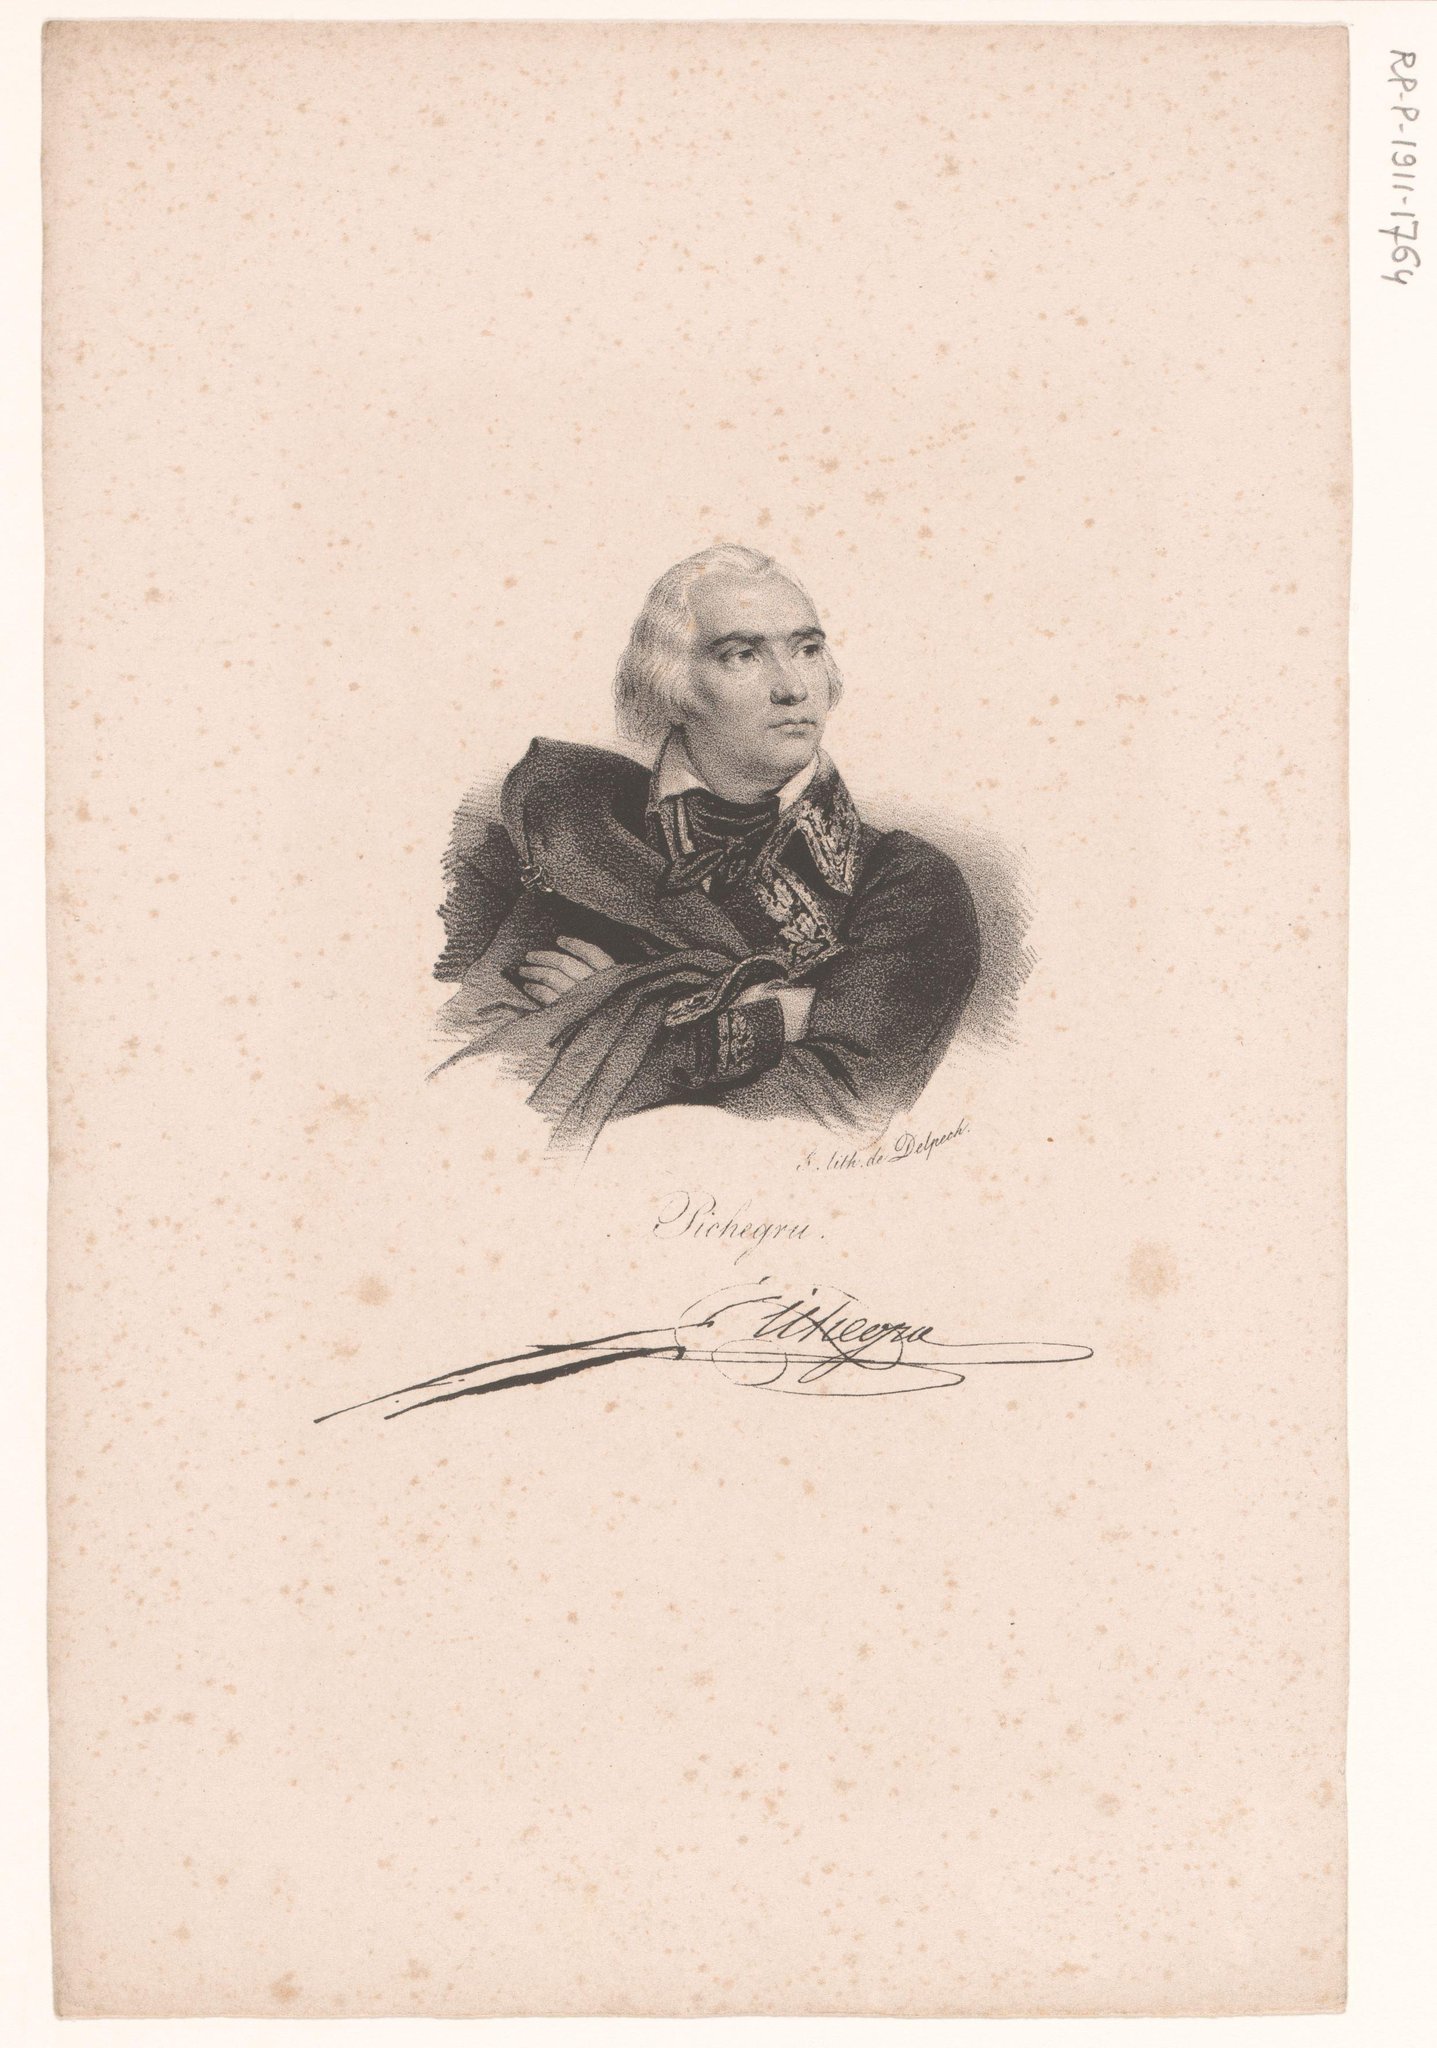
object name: print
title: Portret van Jean-Charles Pichegru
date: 1818-1842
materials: paper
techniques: lithograph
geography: paris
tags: paris, politician, jean-charles pichegru, historical persons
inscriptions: collector's mark: Lugt 2228a